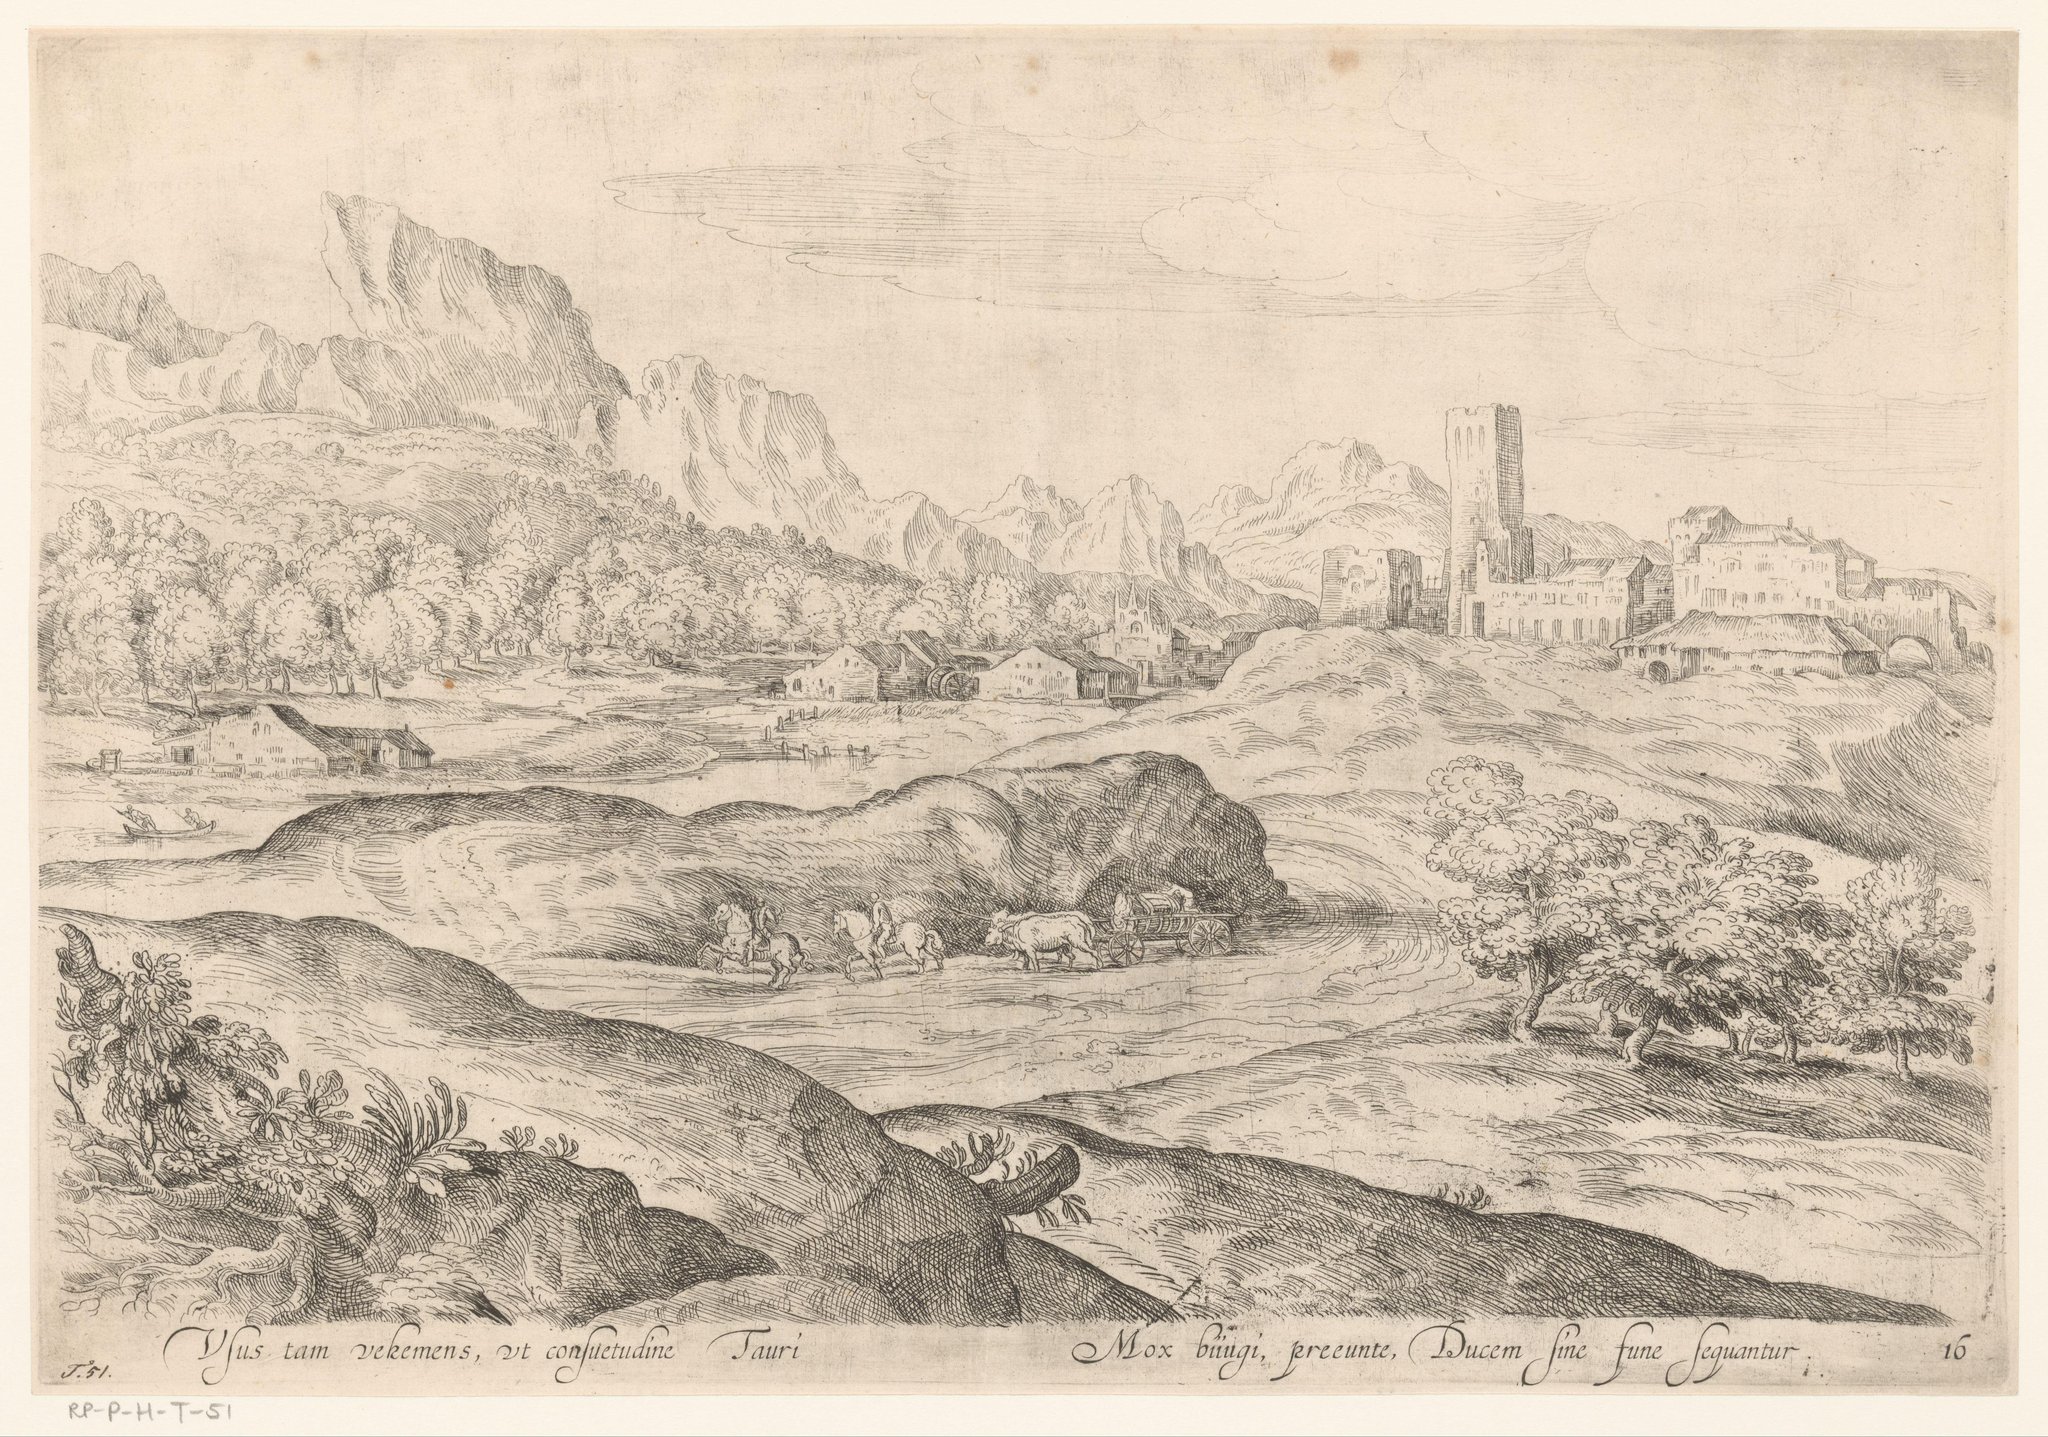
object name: print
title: Usus tam vehemens, ut consuetudine tauri, / Mox biiugi, preeunte, Ducem sine fune sequantur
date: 1600-1699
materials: paper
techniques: etching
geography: italy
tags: riding a horse, ass, or mule; rider, horseman, landscapes, ox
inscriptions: collector's mark: Lugt 11, number: ‘T. 51.’, collector's mark: ‘Hinloopen’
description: Een landschap met een nederzetting. Op de voorgrond rijden twee mannen te paard en achter hen trekken twee ossen een kar. Titel in het Latijn in ondermarge. Genummerd rechtsonder: 16.